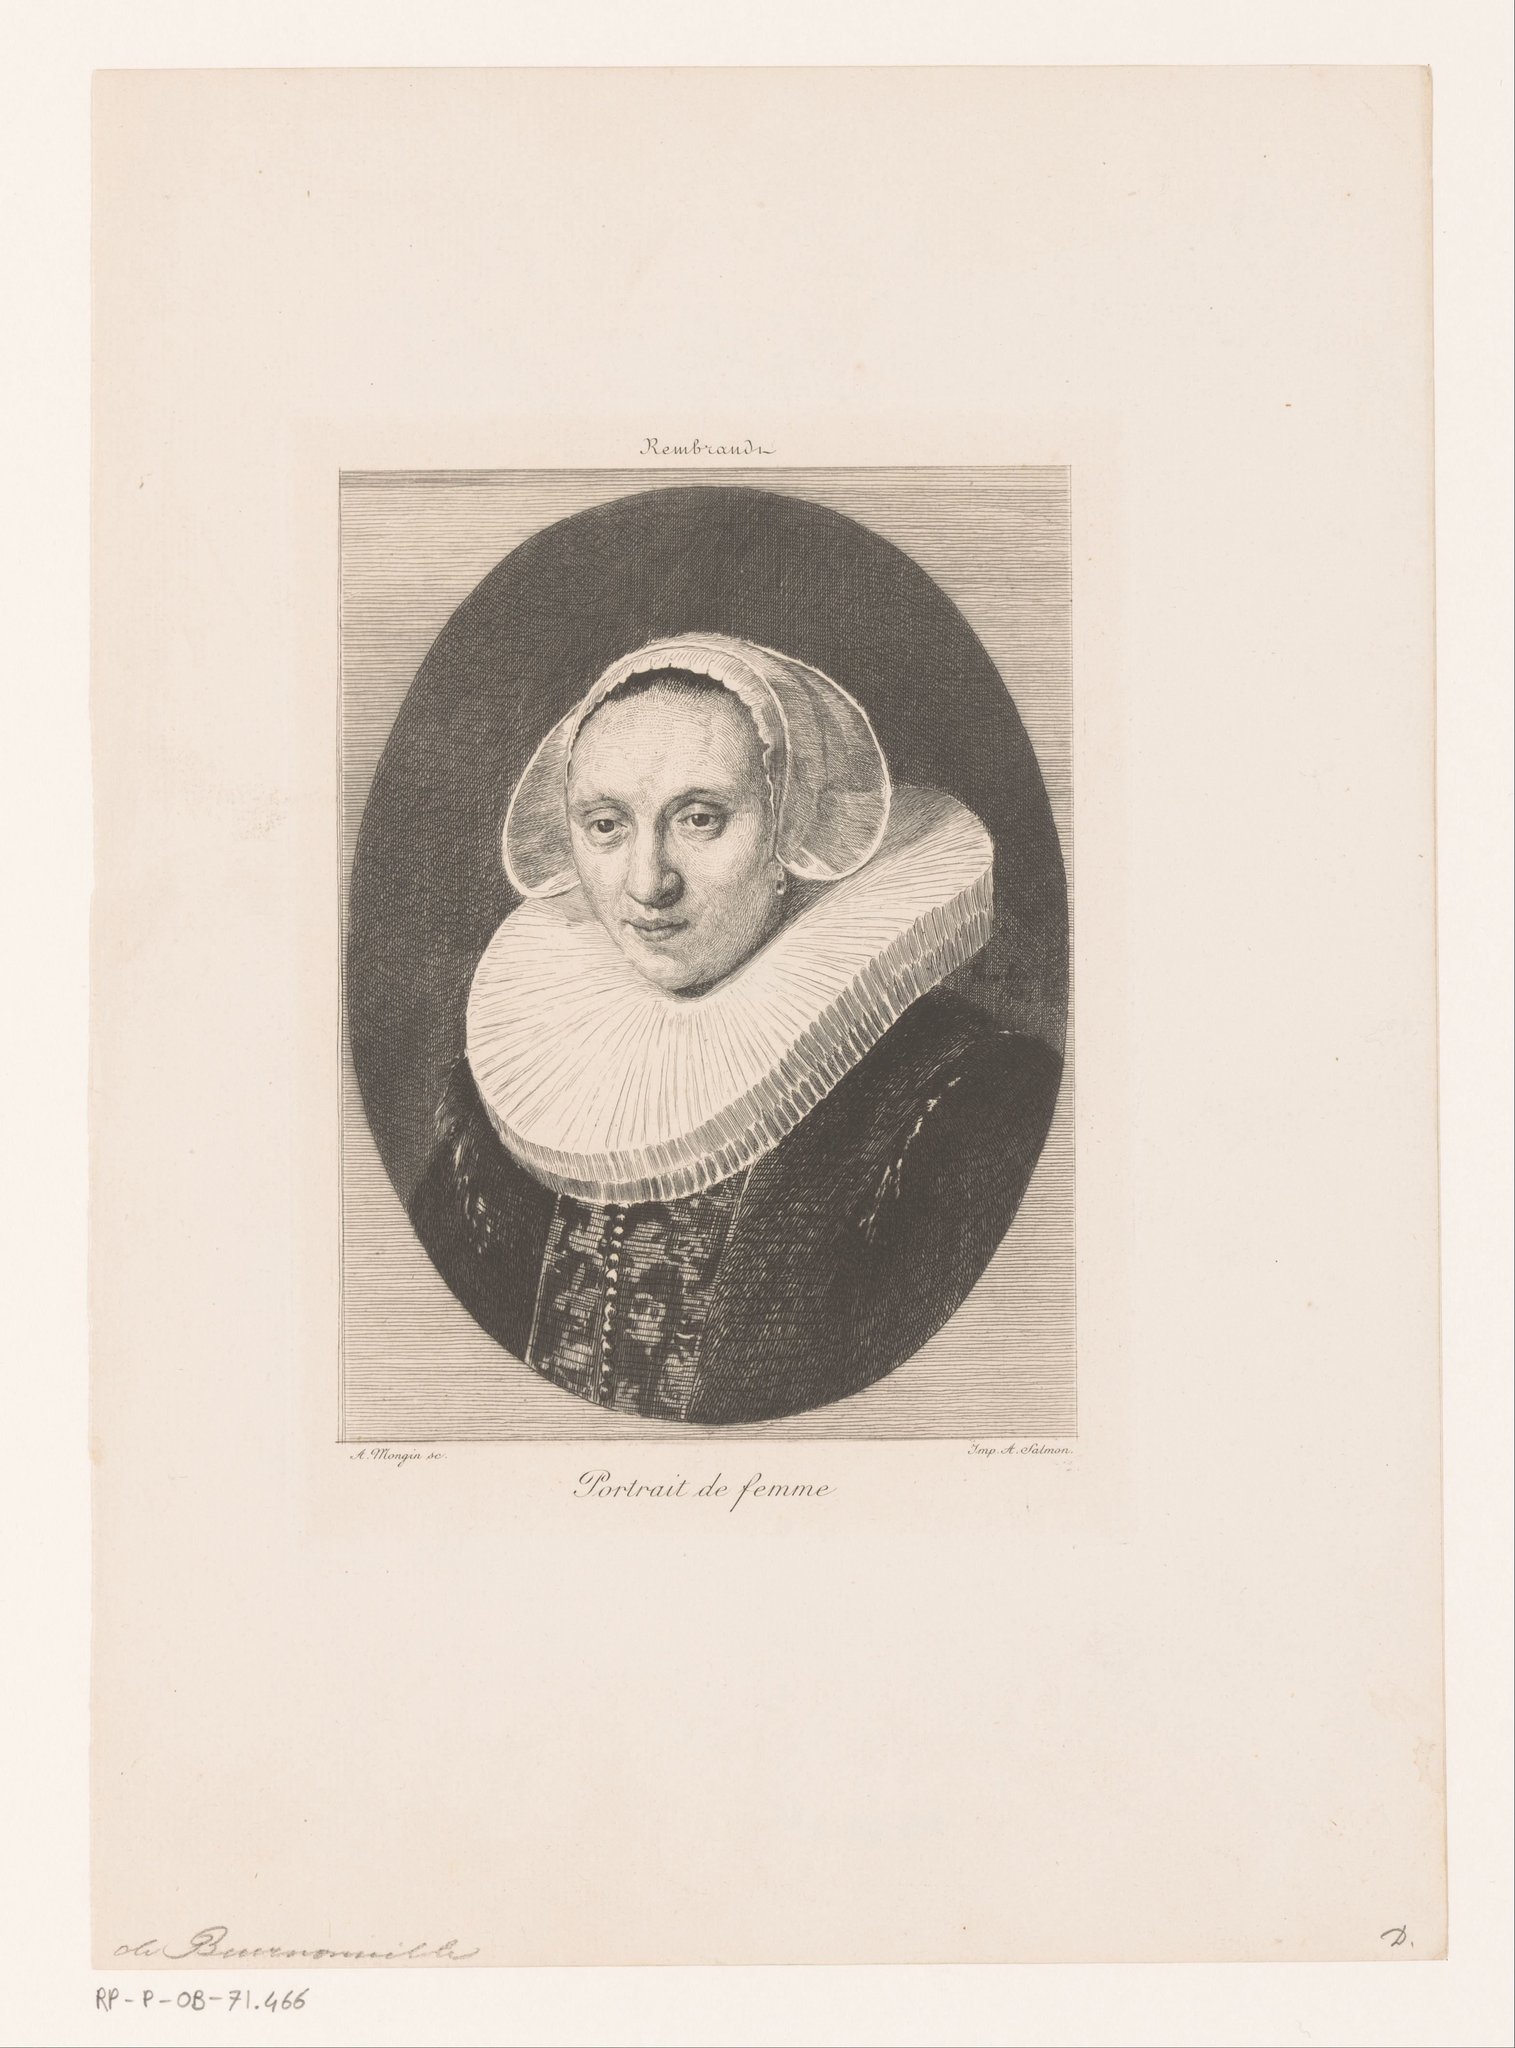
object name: print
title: Portret van een onbekende vrouw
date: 1881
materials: paper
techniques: etching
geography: amsterdam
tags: historical persons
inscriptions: collector's mark: Lugt 2228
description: Prent afkomstig uit een veilingcatalogus: "Catalogue des Tableaux anciens composant la très importante collection de Monsieur le Baron de Beurnonville", uitgegeven in 1881 te Parijs door Pillet en Dumoulin. De veiling vond plaats op 9 tot en met 14 en 16 mei 1881.